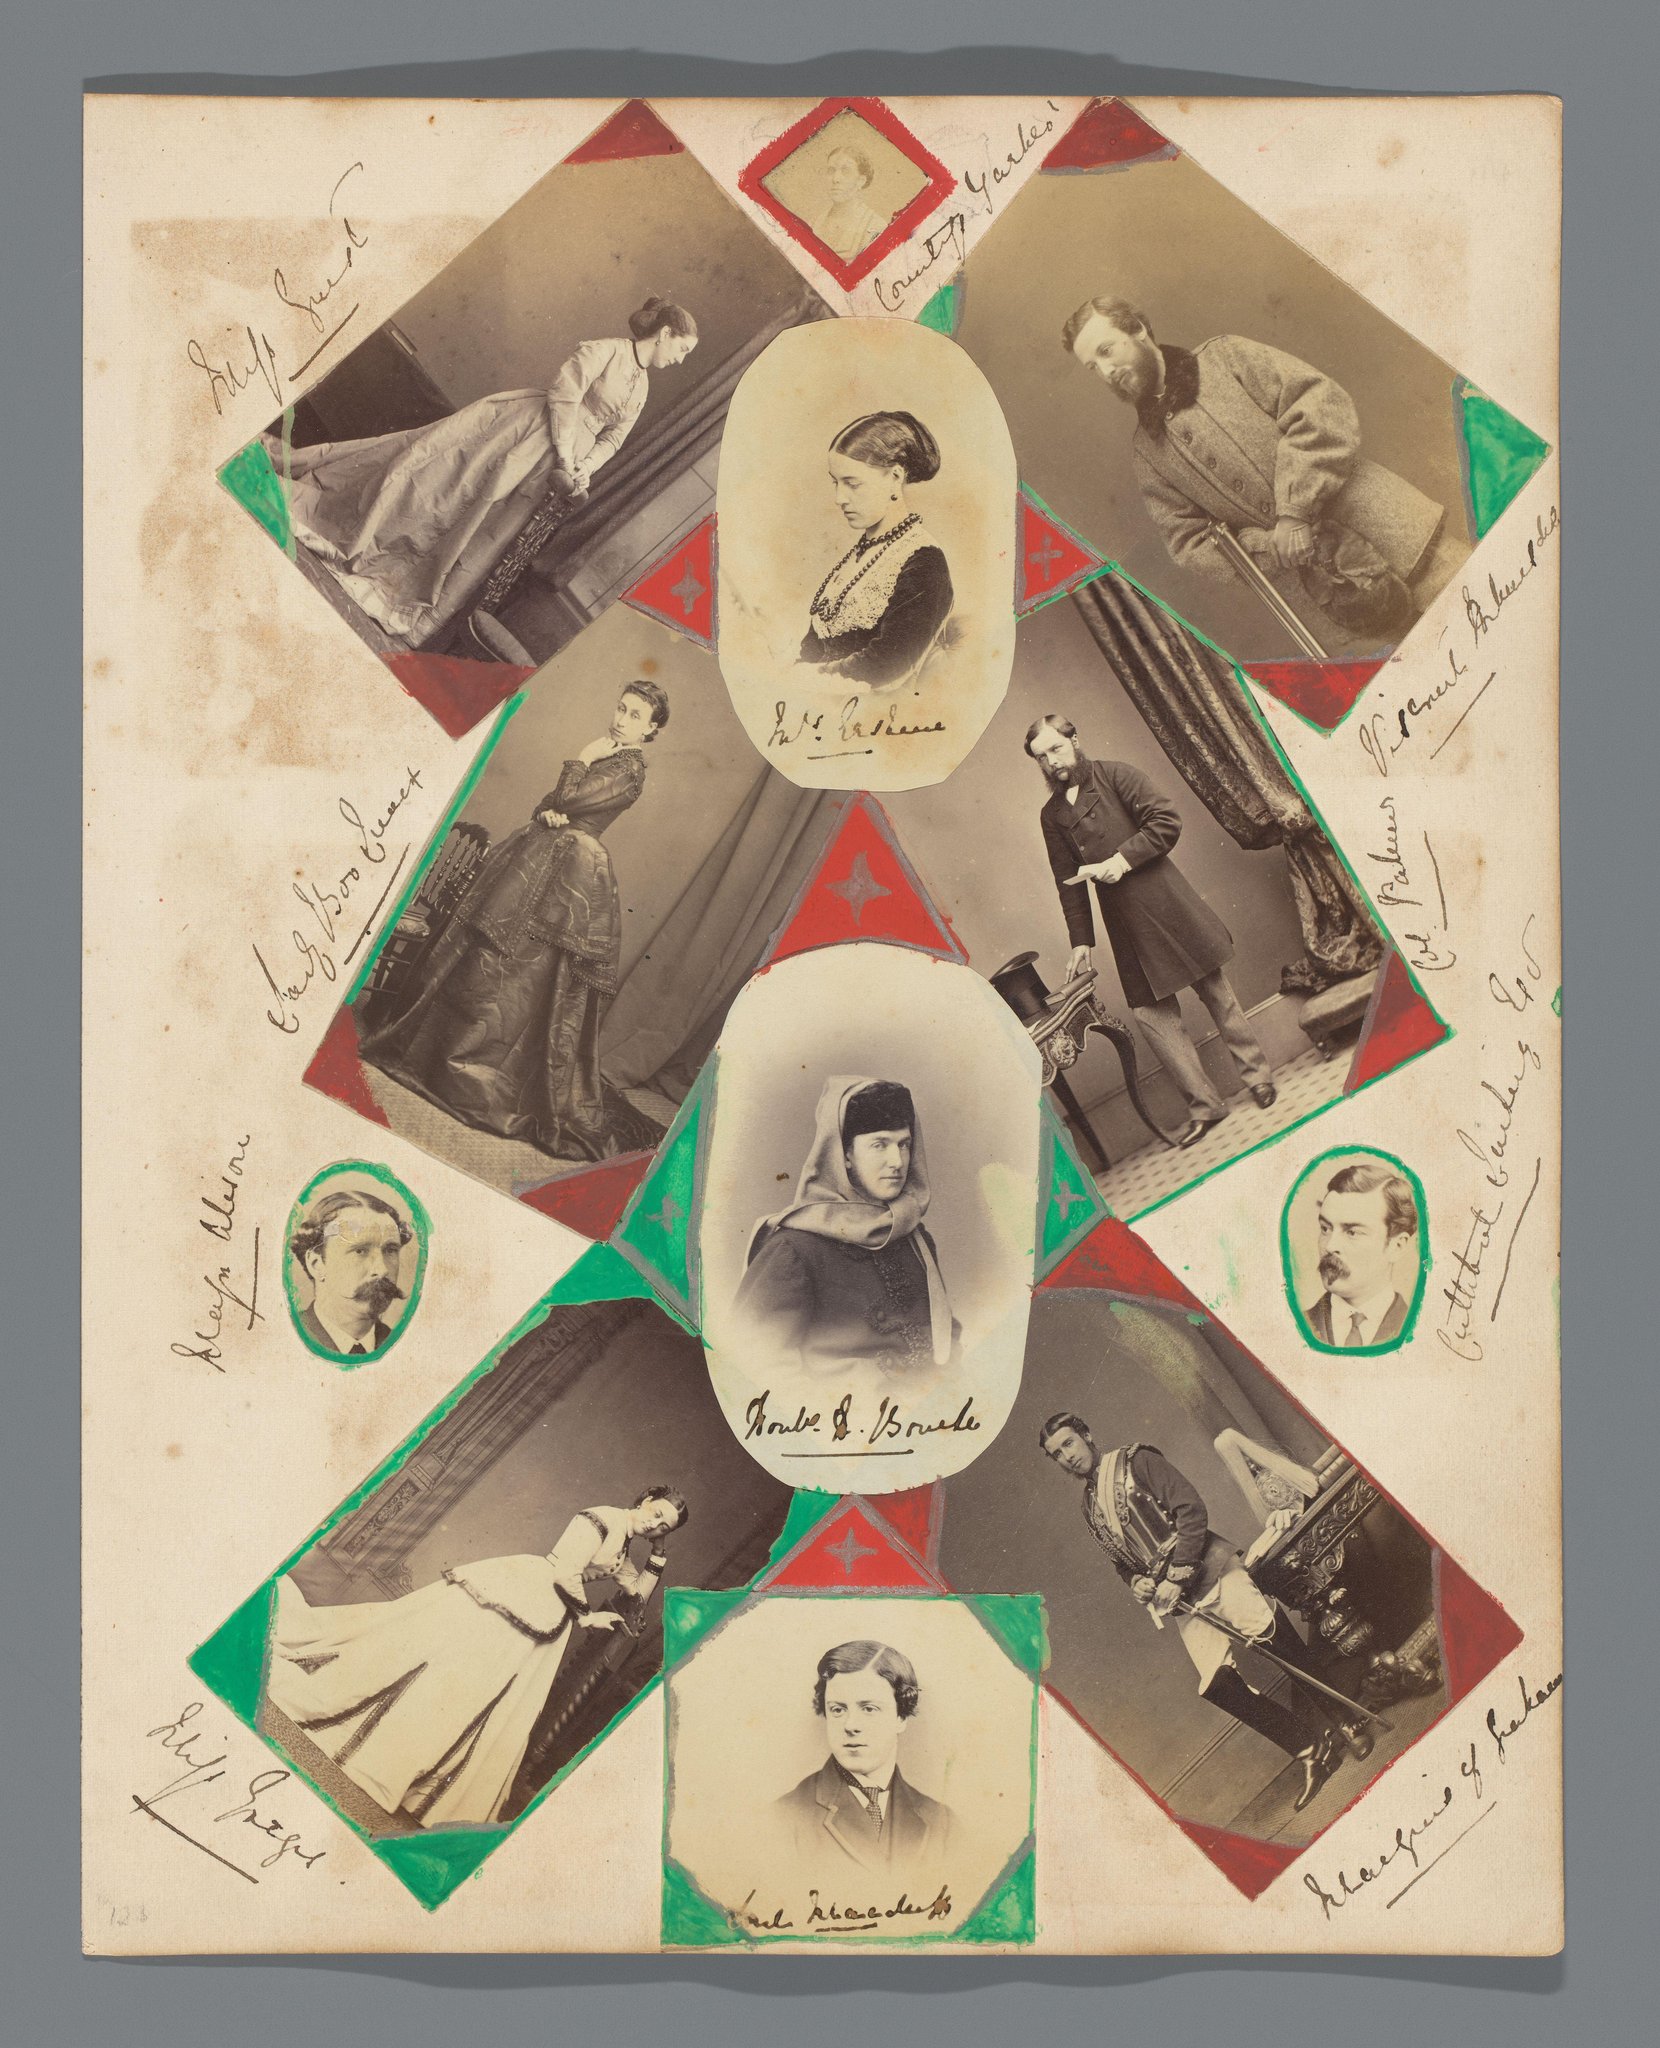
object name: photograph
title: Blad afkomstig uit een fotoalbum, met 12 foto's (ongemonteerde carte-de-visites) en met inkt aangebrachte randversieringen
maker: mary georgiana filmer (lady)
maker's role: fotograaf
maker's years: 1838-1903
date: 1865-1870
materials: ink, paper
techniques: albumen print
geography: united kingdom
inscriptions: inscription: ‘paginanummer 123.’, inscription: ‘namen van de voorgestelde personen.’